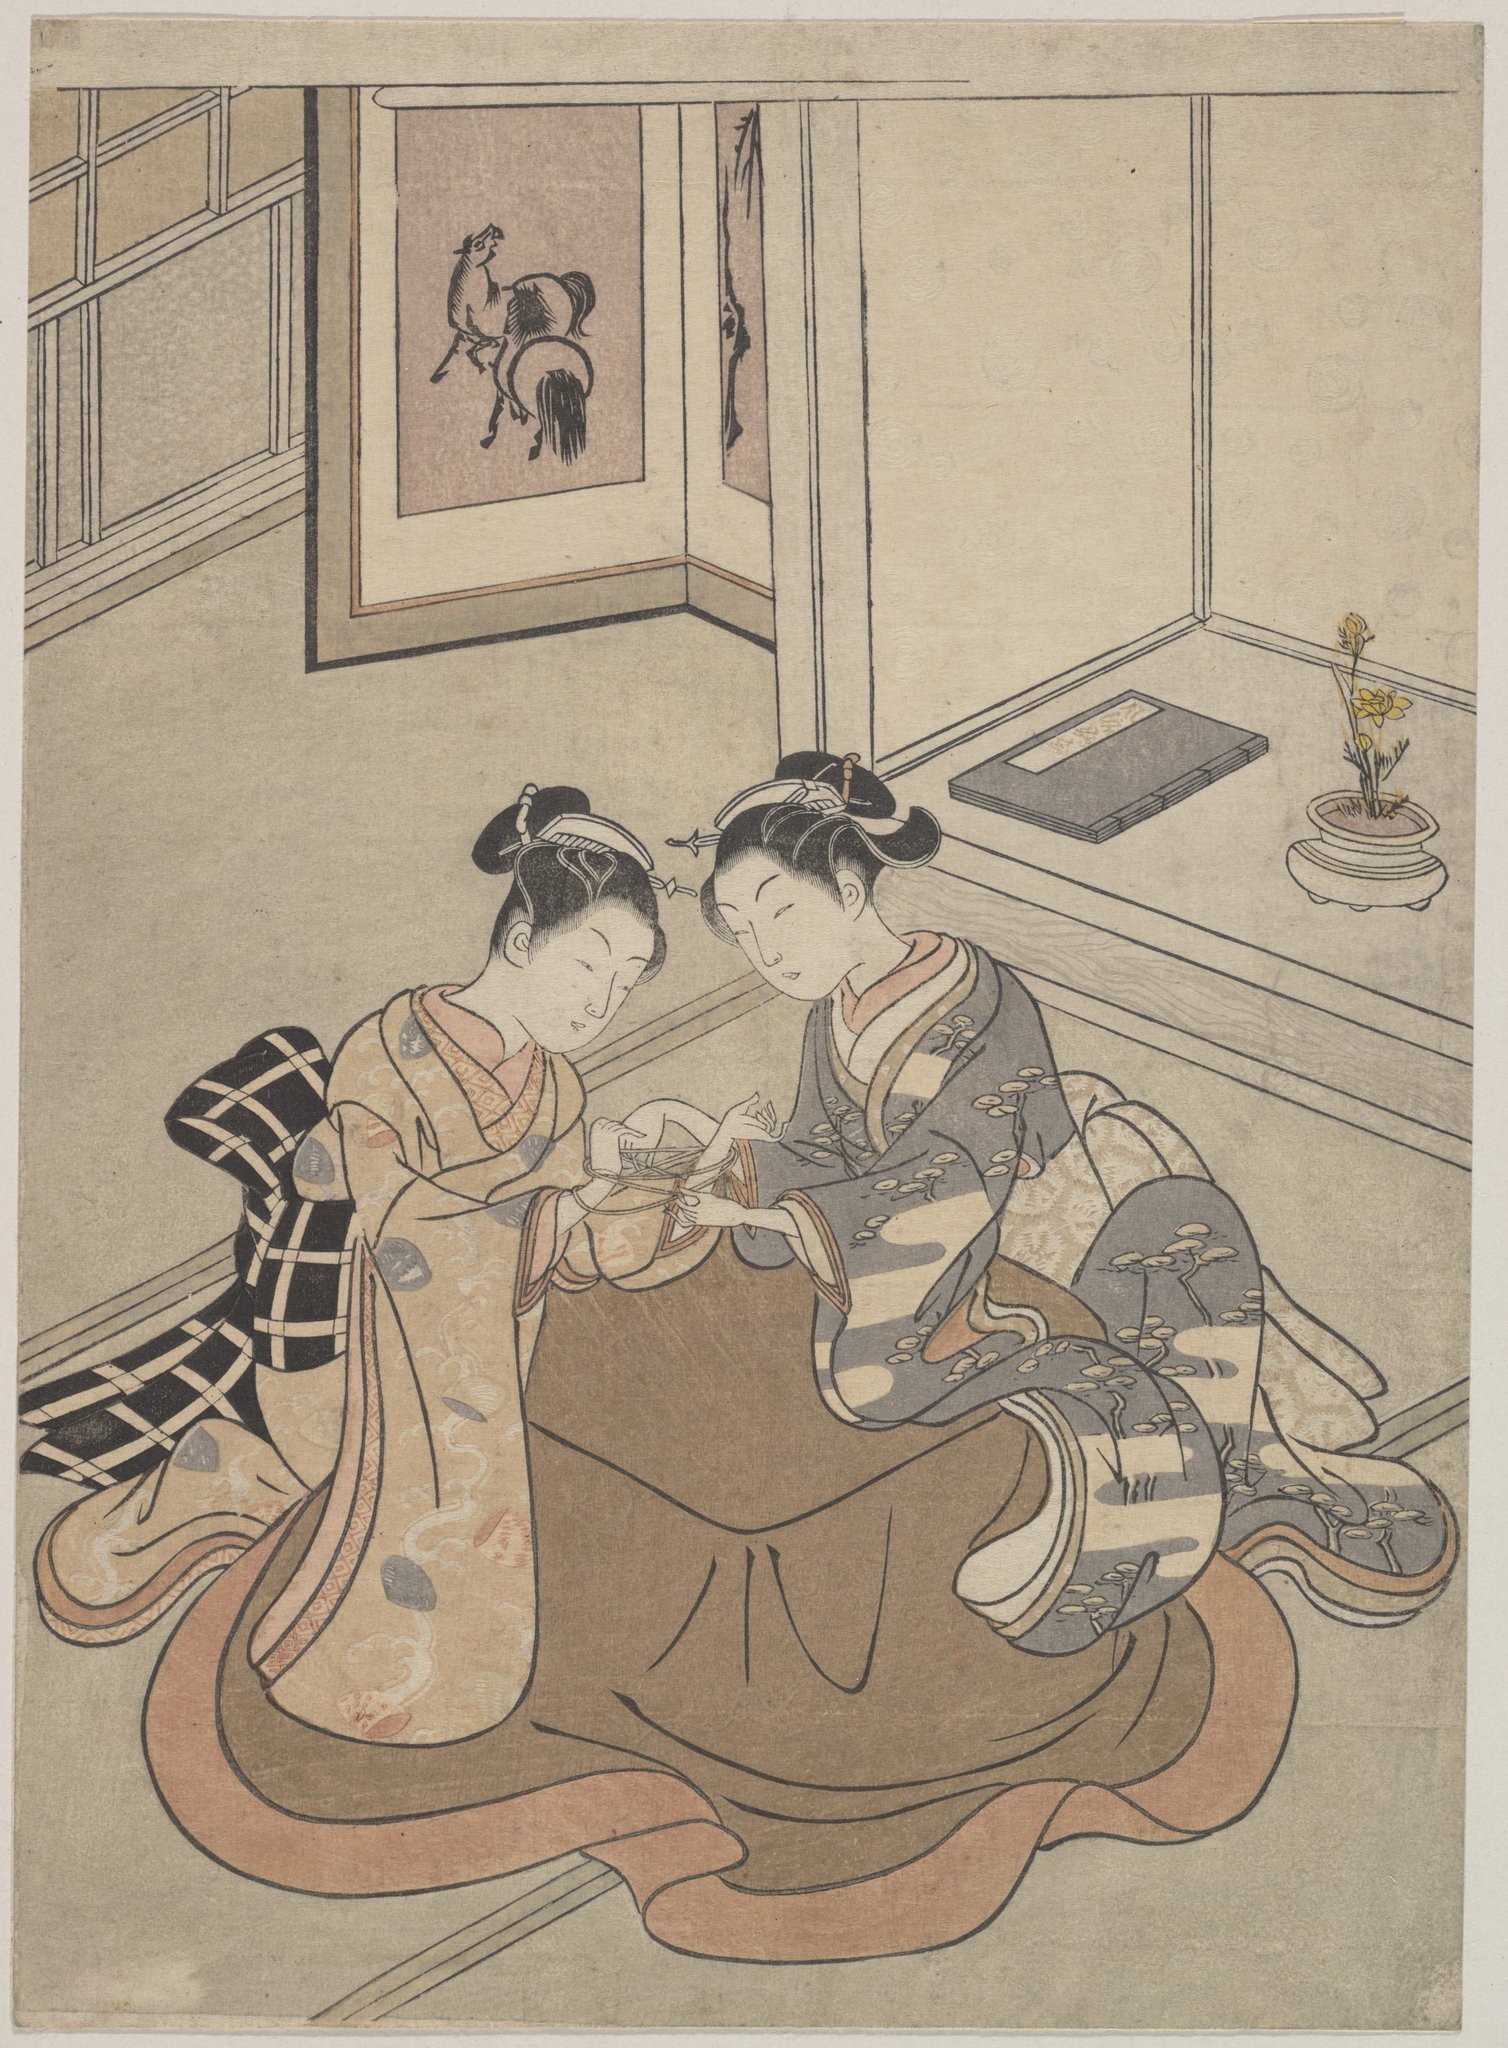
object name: print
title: Two Young Women Seated by a Kotatsu Playing Cat's Cradle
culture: japanese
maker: suzuki harunobu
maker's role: artist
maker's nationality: japanese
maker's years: 1725-1770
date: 1765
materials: ink, paper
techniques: woodblock print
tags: women,playing